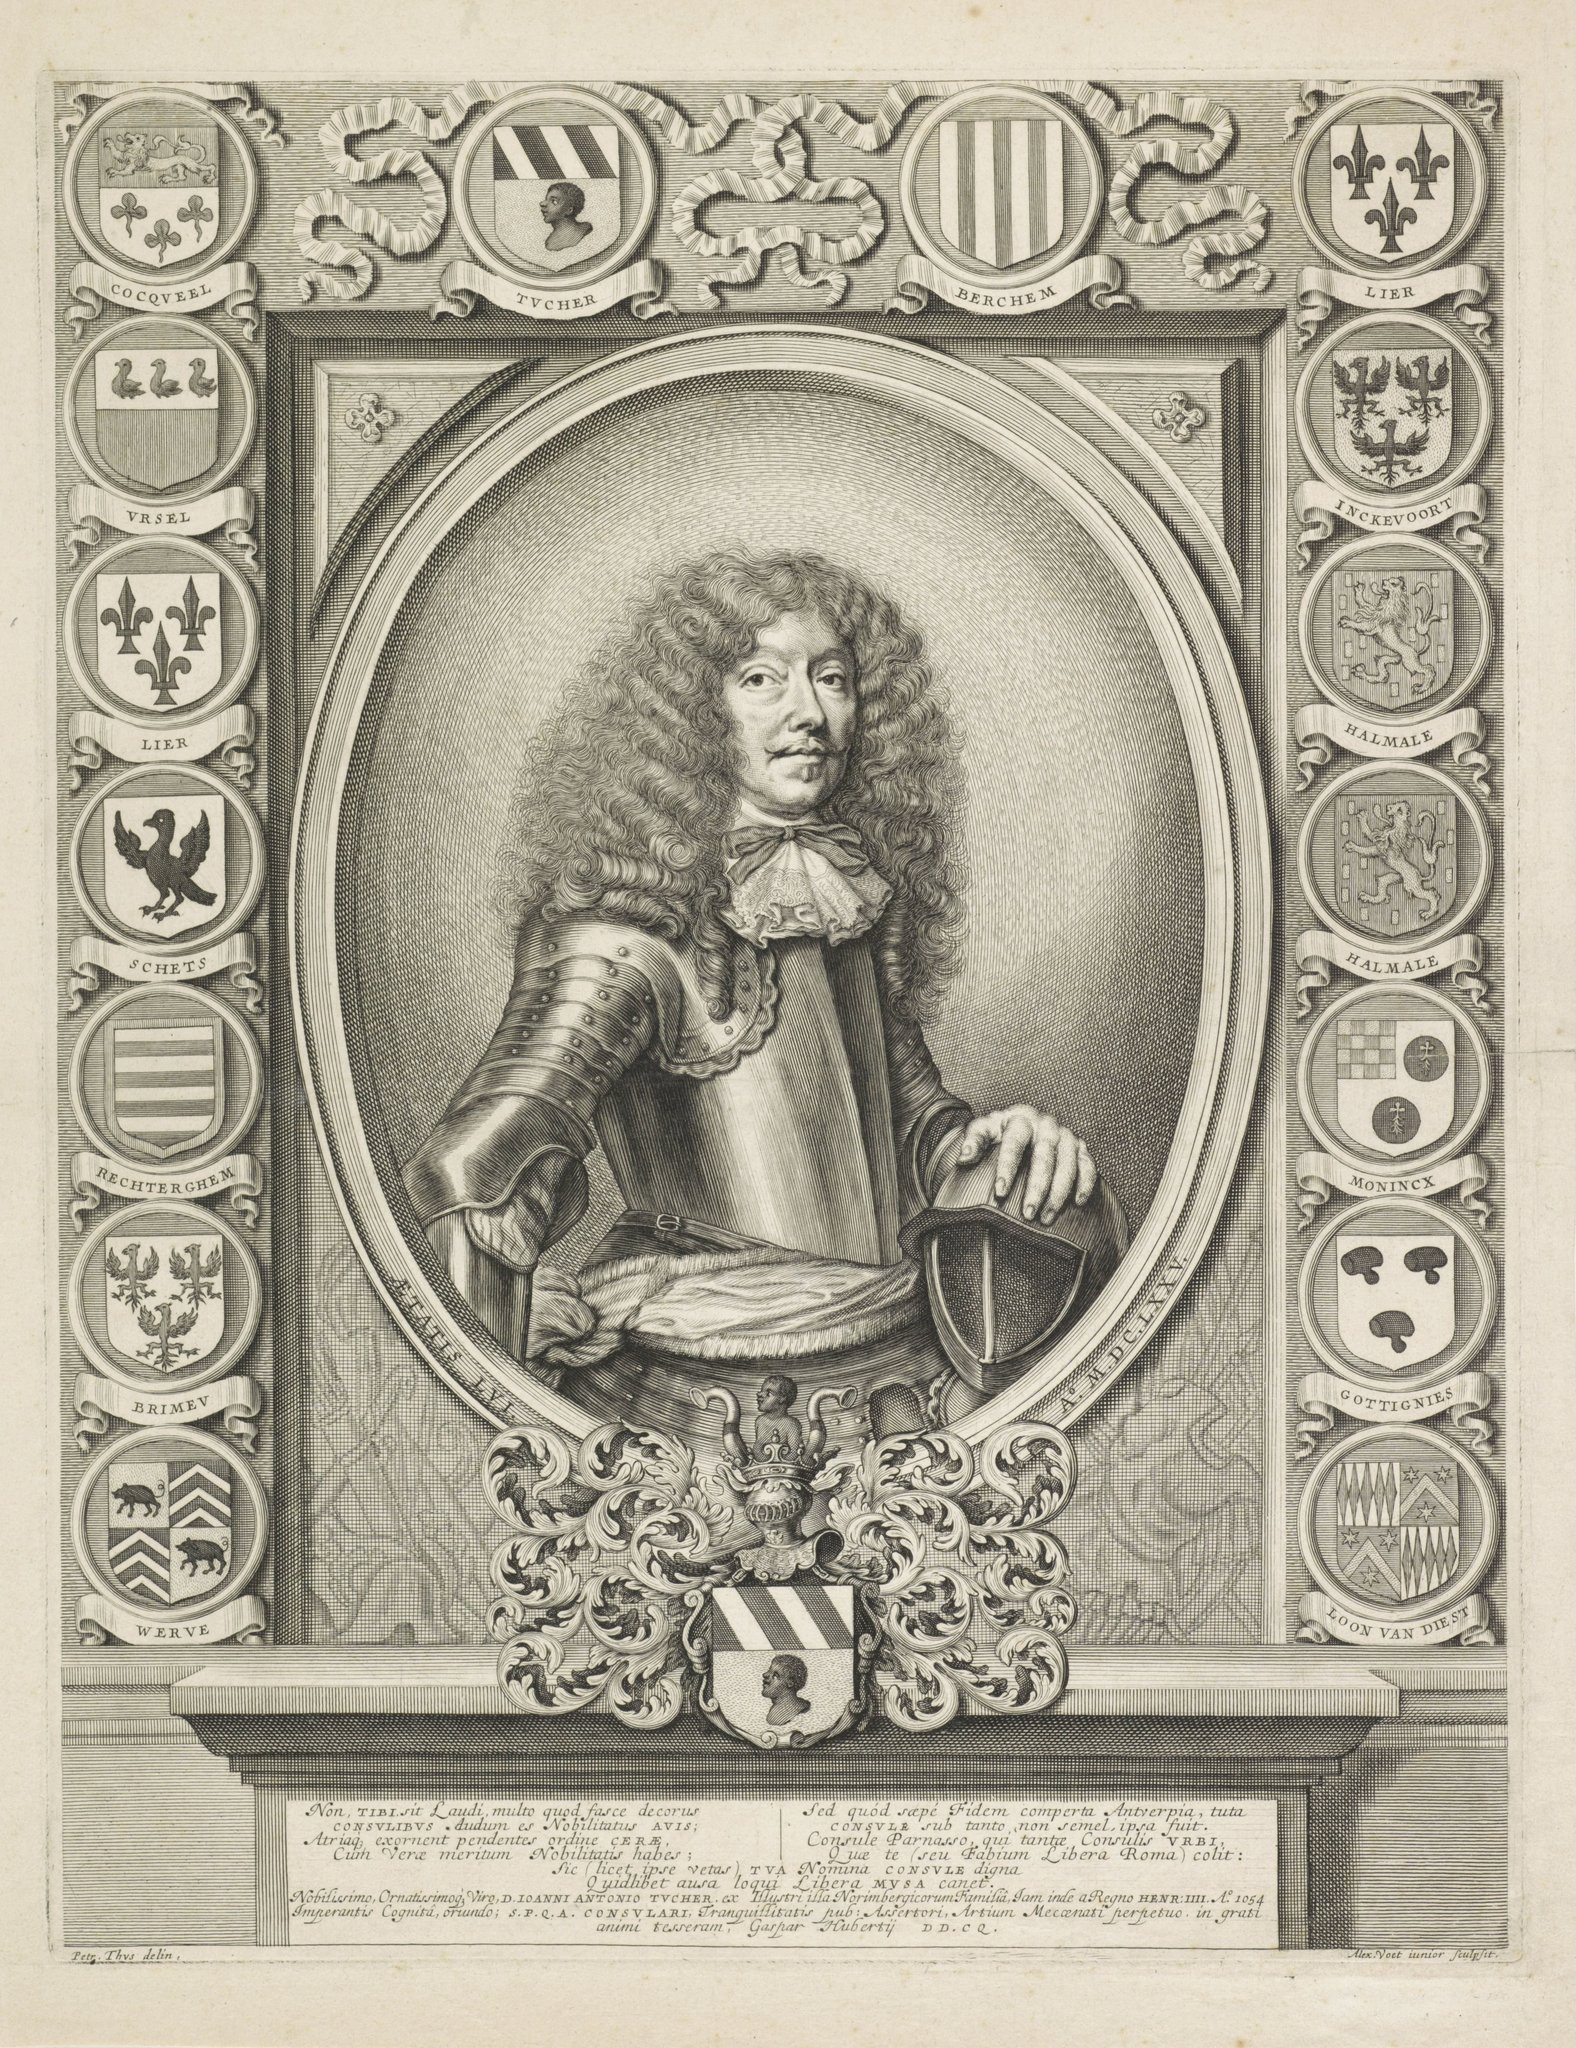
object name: print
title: Portret van Johannes Antonius Tucher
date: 1675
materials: paper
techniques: engraving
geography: antwerp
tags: antwerp, johannes antonius tucher, helmet, armour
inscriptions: date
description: Portret van Johannes Antonius Tucher, op 56-jarige leeftijd, in harnas, zijn hand rustend op een helm. Onder het portret zijn familiewapen.